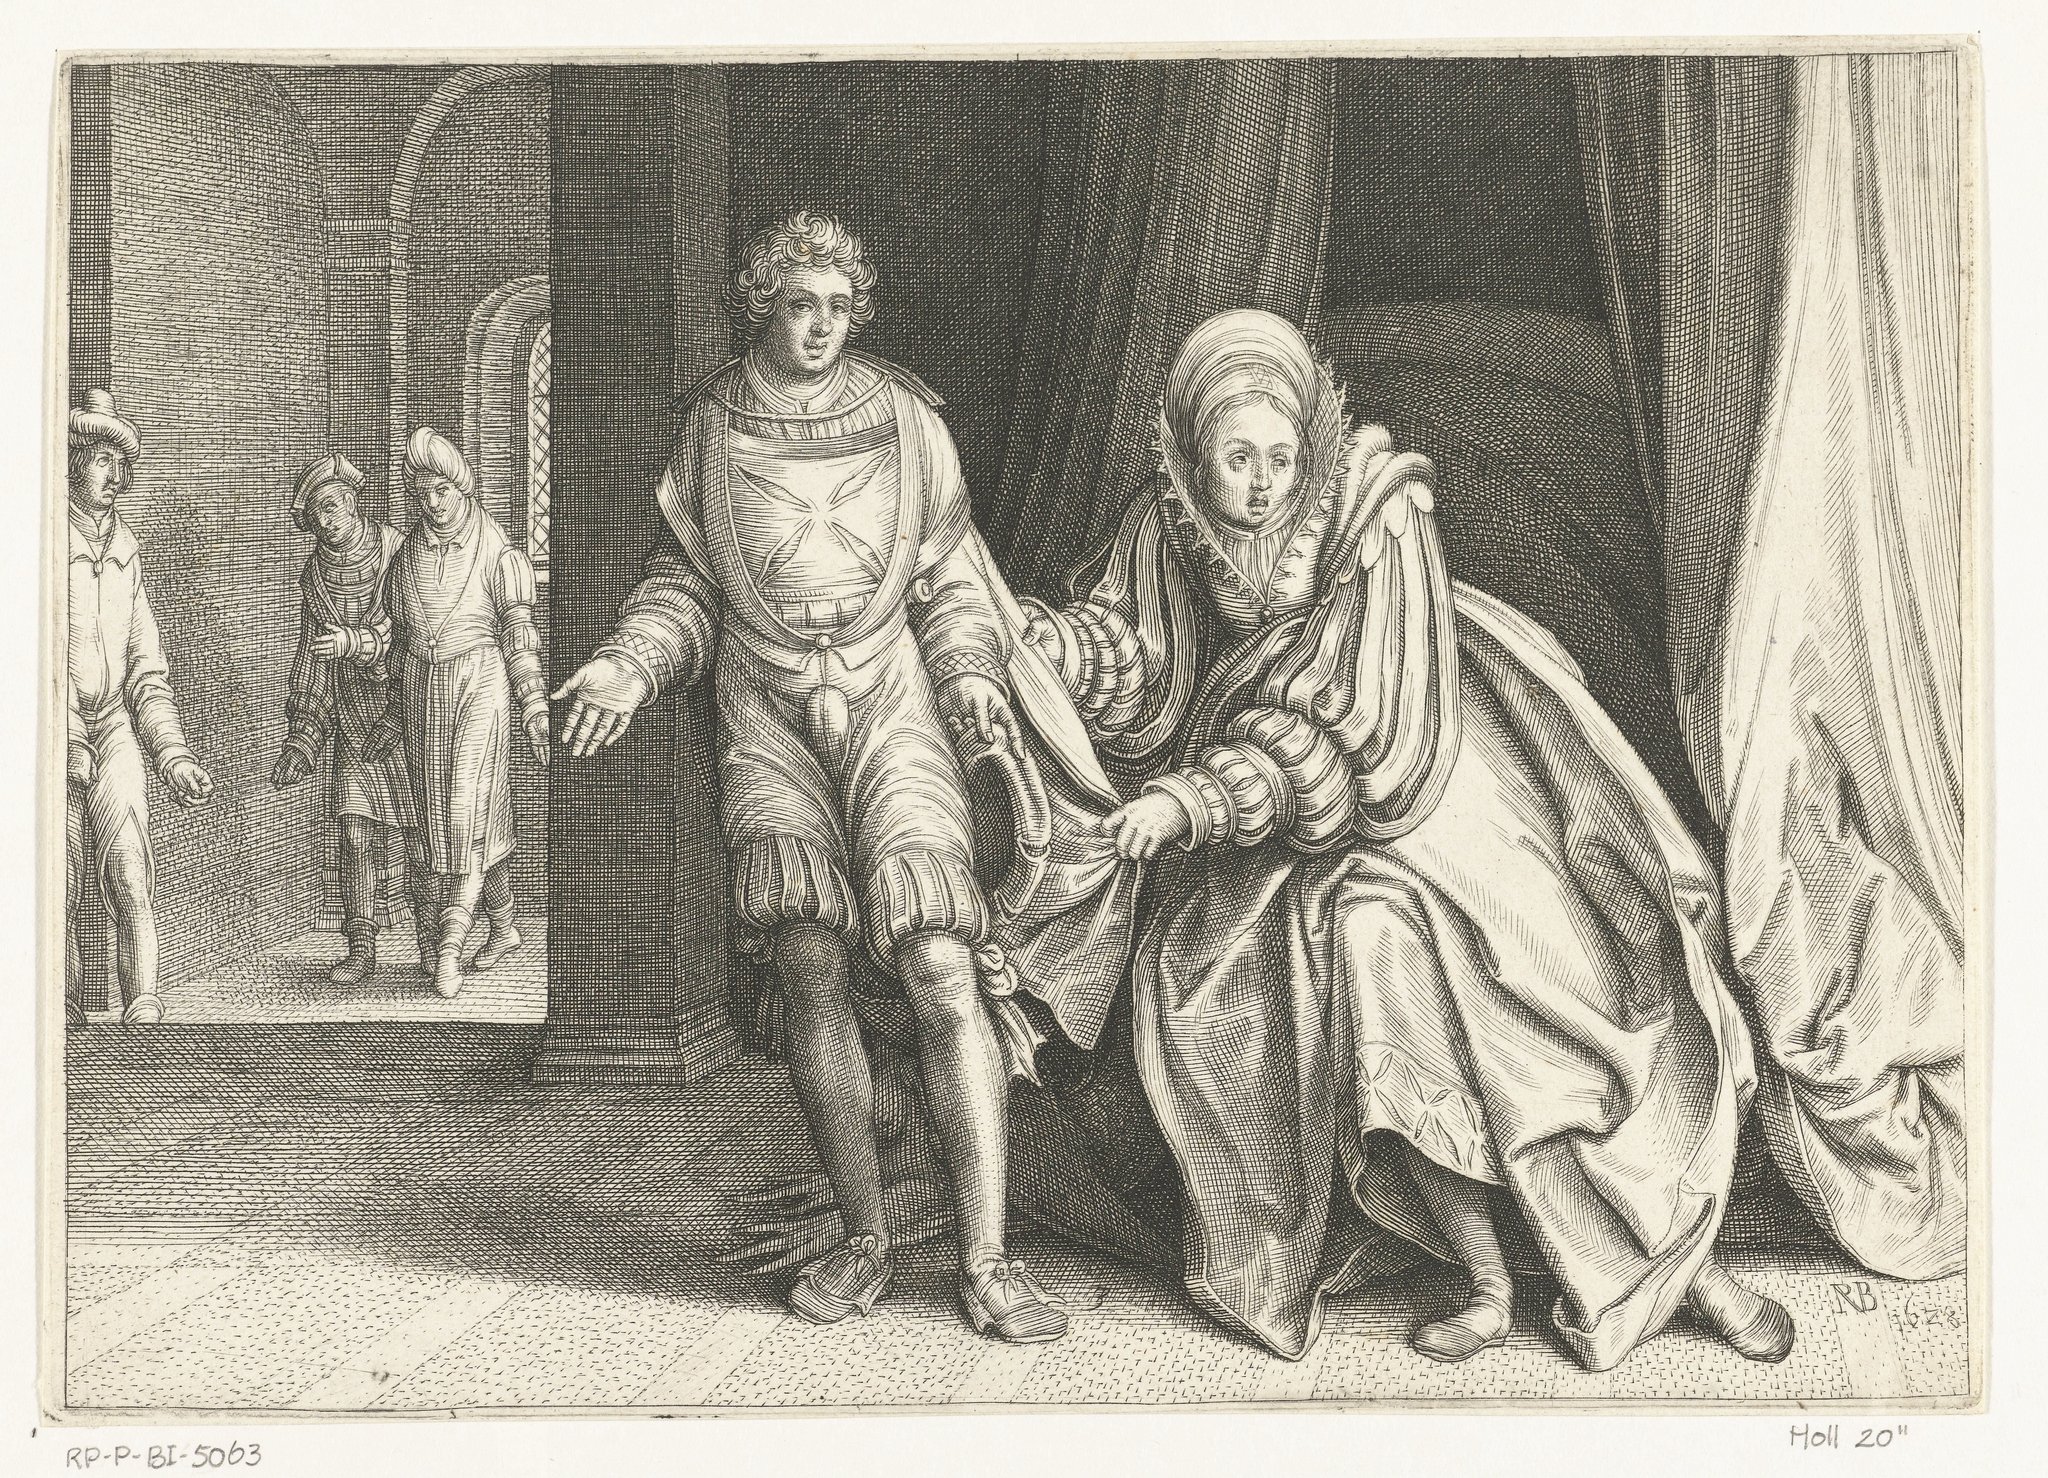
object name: print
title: Jozef en de vrouw van Potifar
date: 1628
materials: paper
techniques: engraving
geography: netherlands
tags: potiphar's wife trying to seduce joseph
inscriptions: collector's mark: Lugt 2228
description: Prent uit serie van zes prenten met het verhaal van Jozef. De serie is geïnspireerd op een vergelijkbare reeks van Lucas van Leyden.